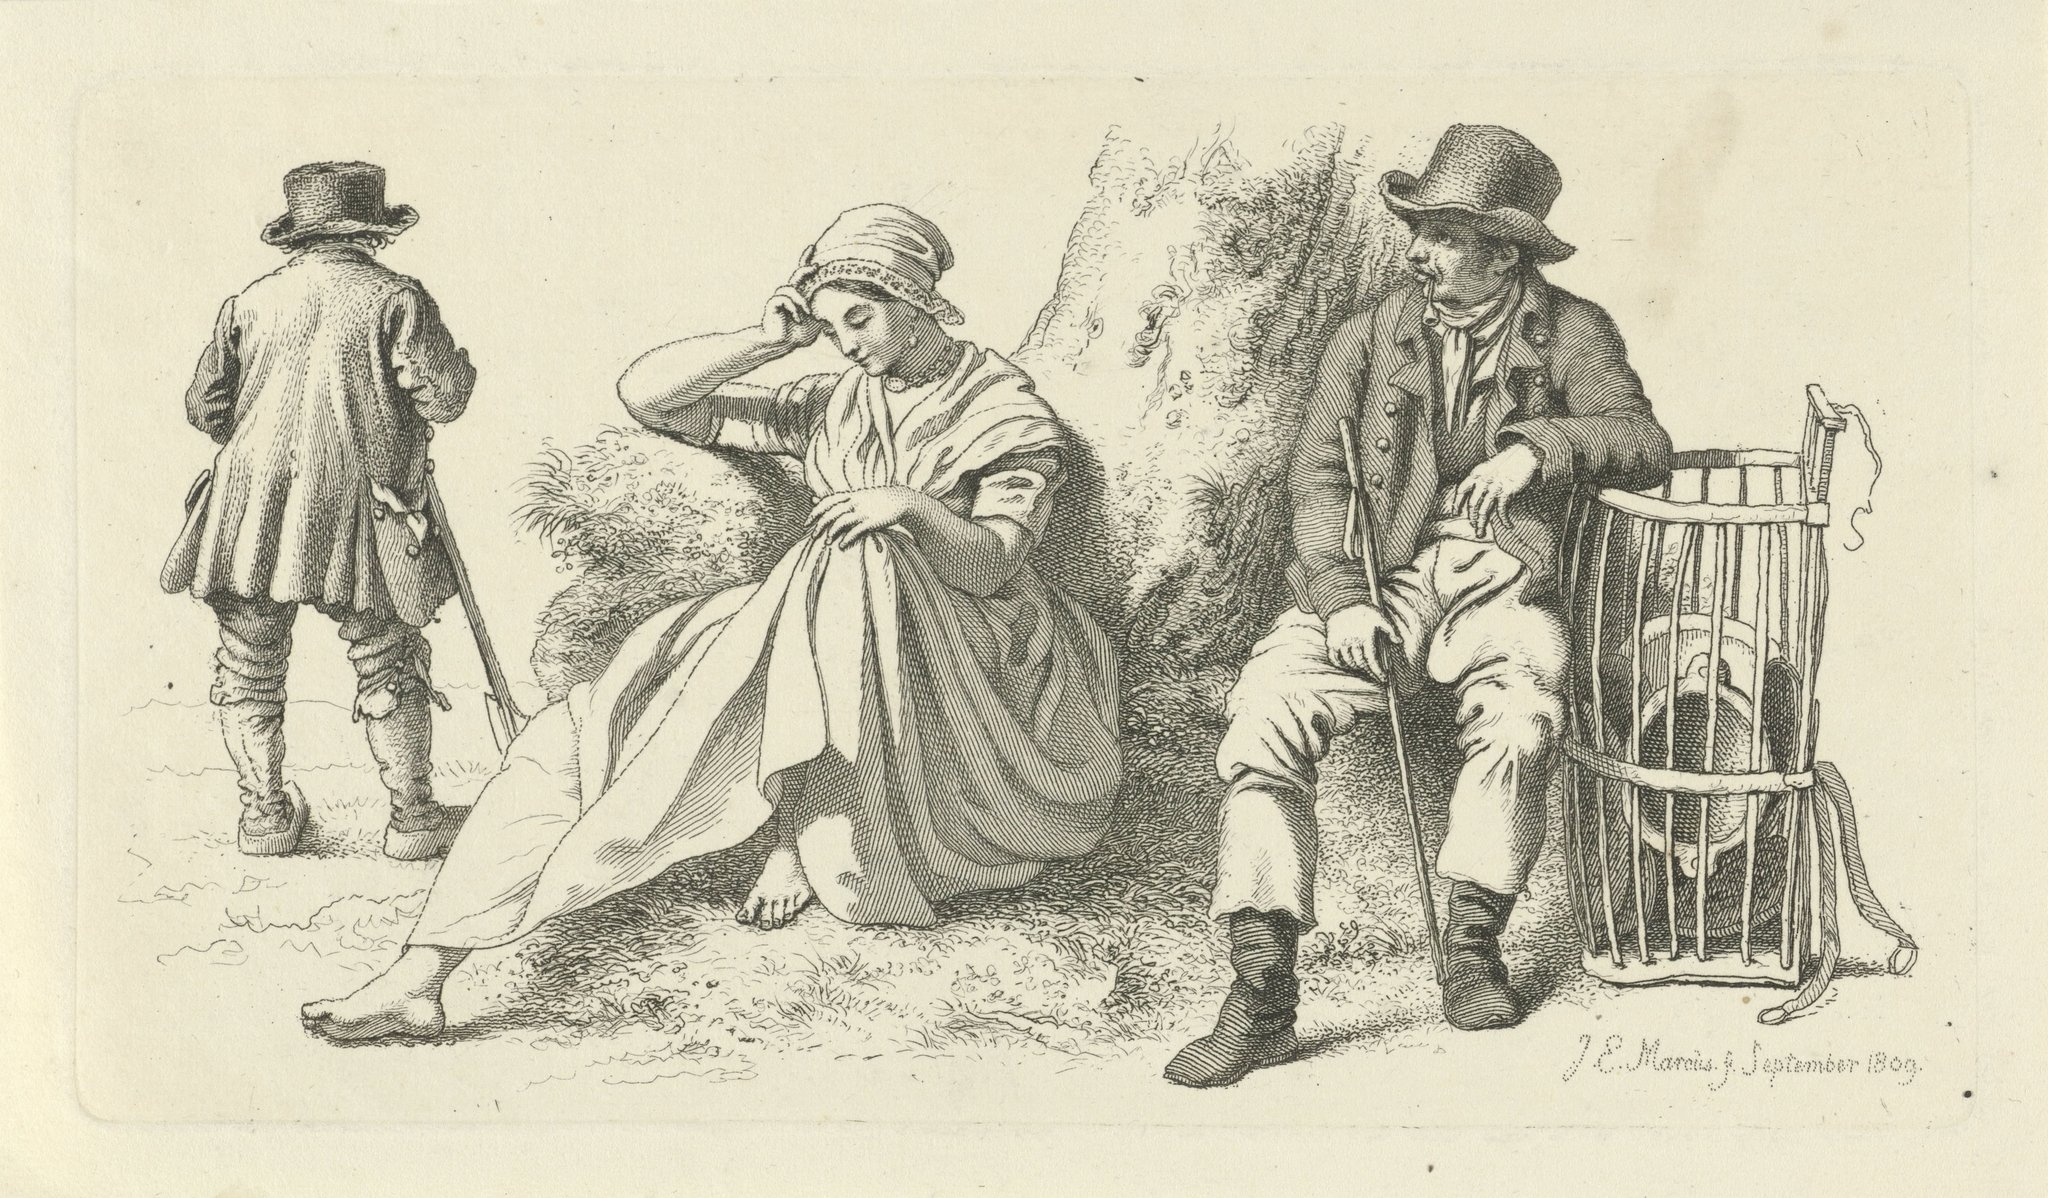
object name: print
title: Studie-prentwerk / Etudes gravées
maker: jacob ernst marcus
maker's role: draughtsman, print maker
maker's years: 1774-1826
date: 1809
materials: paper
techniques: etching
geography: amsterdam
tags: container made of plant material other than wood: basket, sitting on the ground - aa - female human figure, standing figure (+ back view)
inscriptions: collector's mark: Lugt 2228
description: Serie voor het eerst uitgegeven door Jacob Ernst Marcus onder de titel Studiebeelden en Fragmenten. Amsterdam: ca.1816. Later heruitgegeven als: Studie-prentwerk/ Etudes gravées.